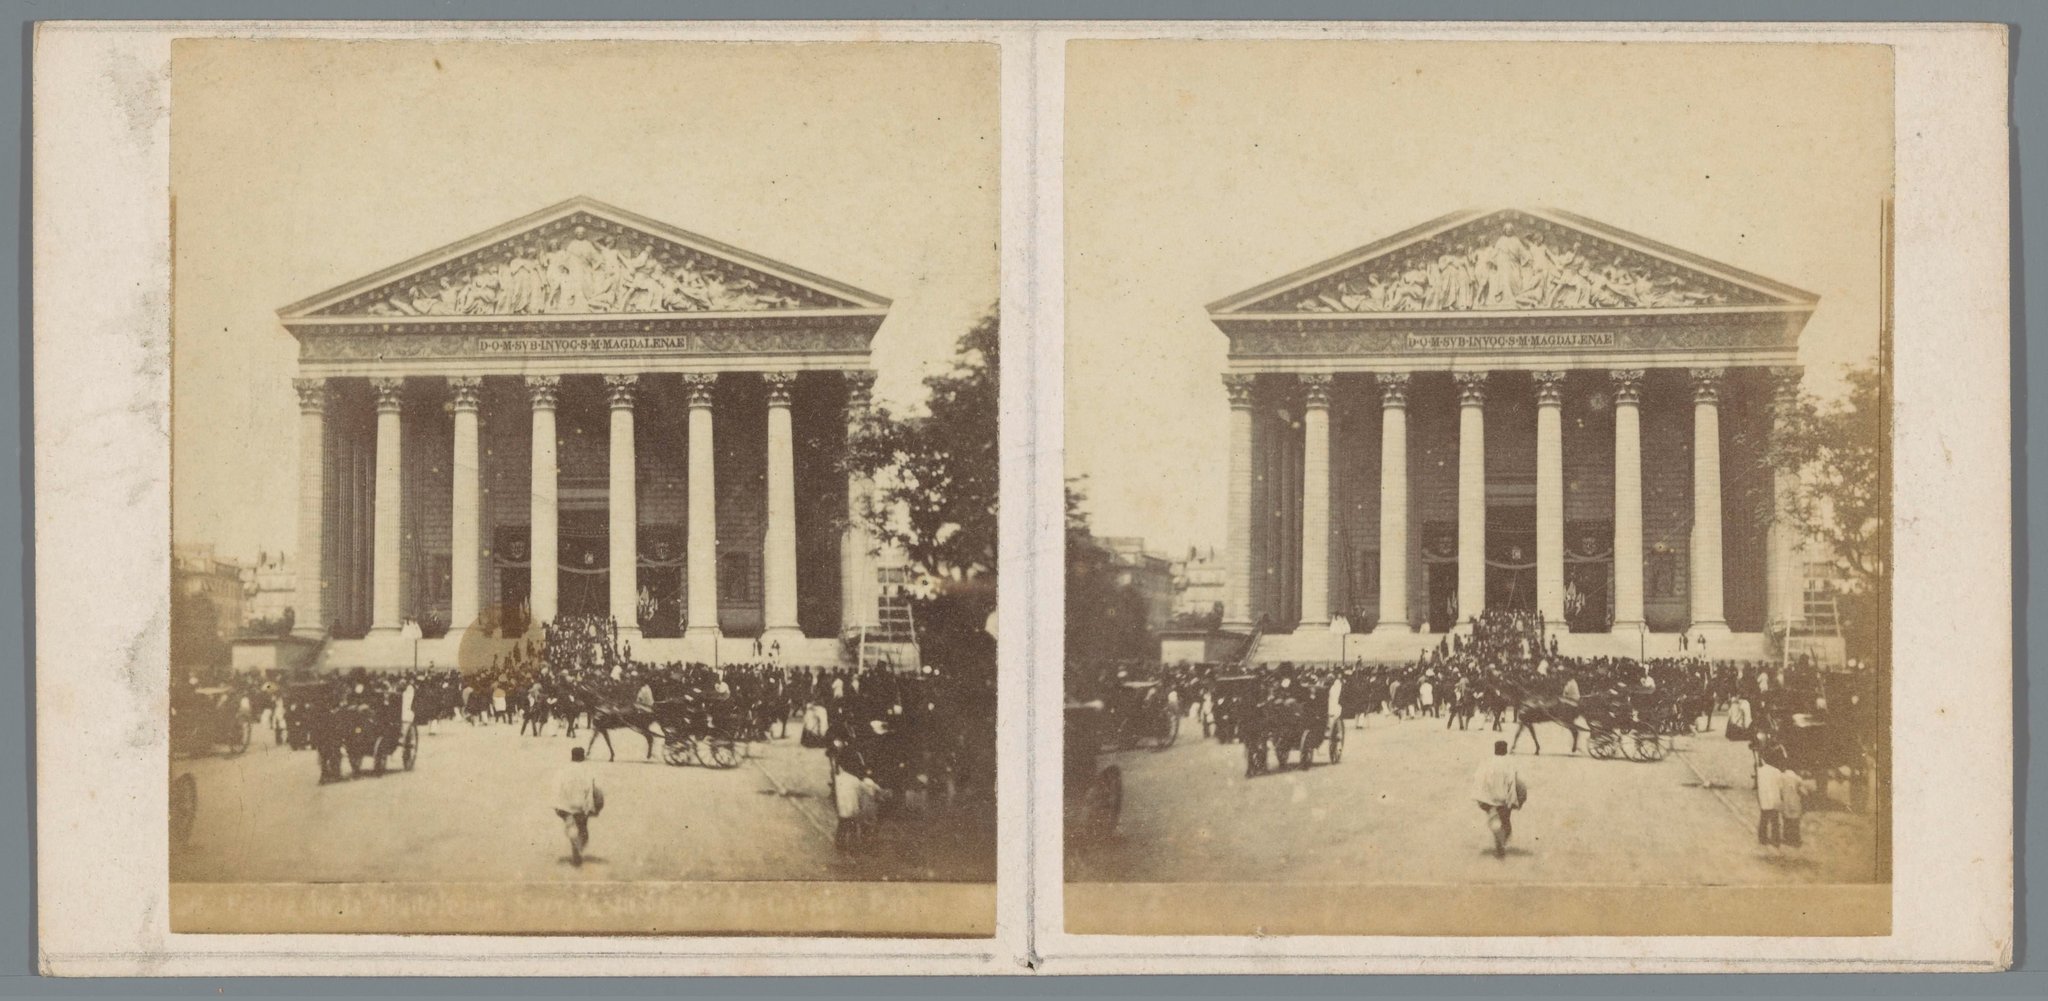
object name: stereograph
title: Gezicht op La Madeleine in Parijs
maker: Anonymous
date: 1860-1875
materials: cardboard, photographic support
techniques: albumen print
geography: paris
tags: parts of church exterior and annexes: façade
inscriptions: inscription: ‘Madeleine Paris’